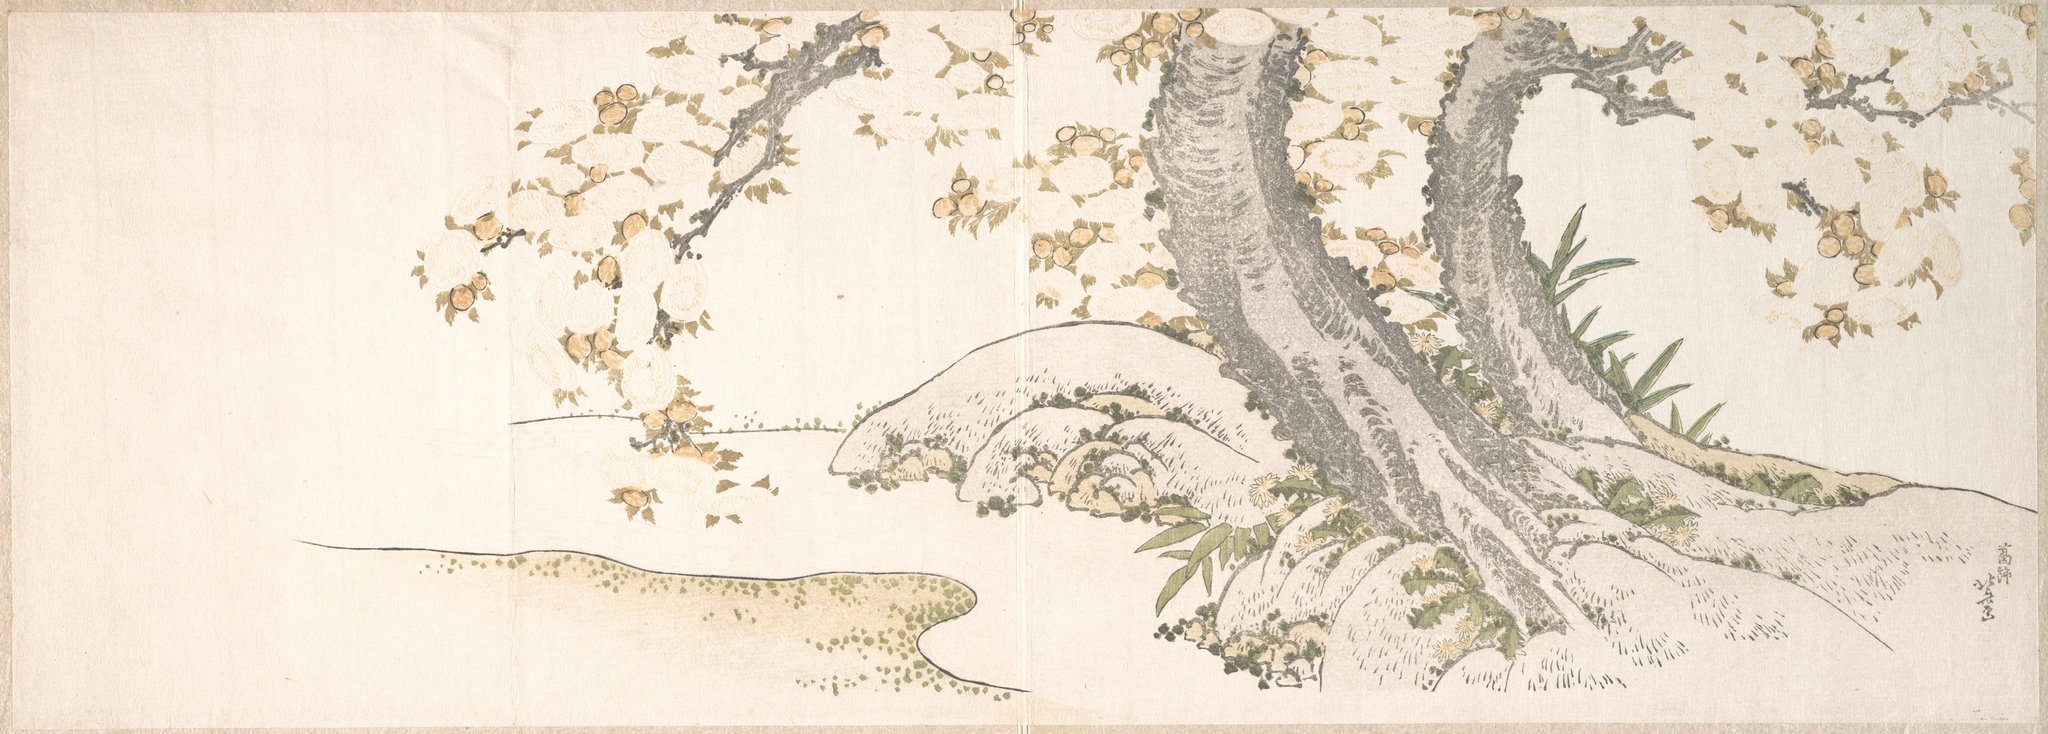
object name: print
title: Blossoming Cherry Trees by a Stream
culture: japanese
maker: katsushika hokusai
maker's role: artist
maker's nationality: japanese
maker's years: 1760-1849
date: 1760-1849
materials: ink, paper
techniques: surimono, woodblock print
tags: rivers,flowers,trees